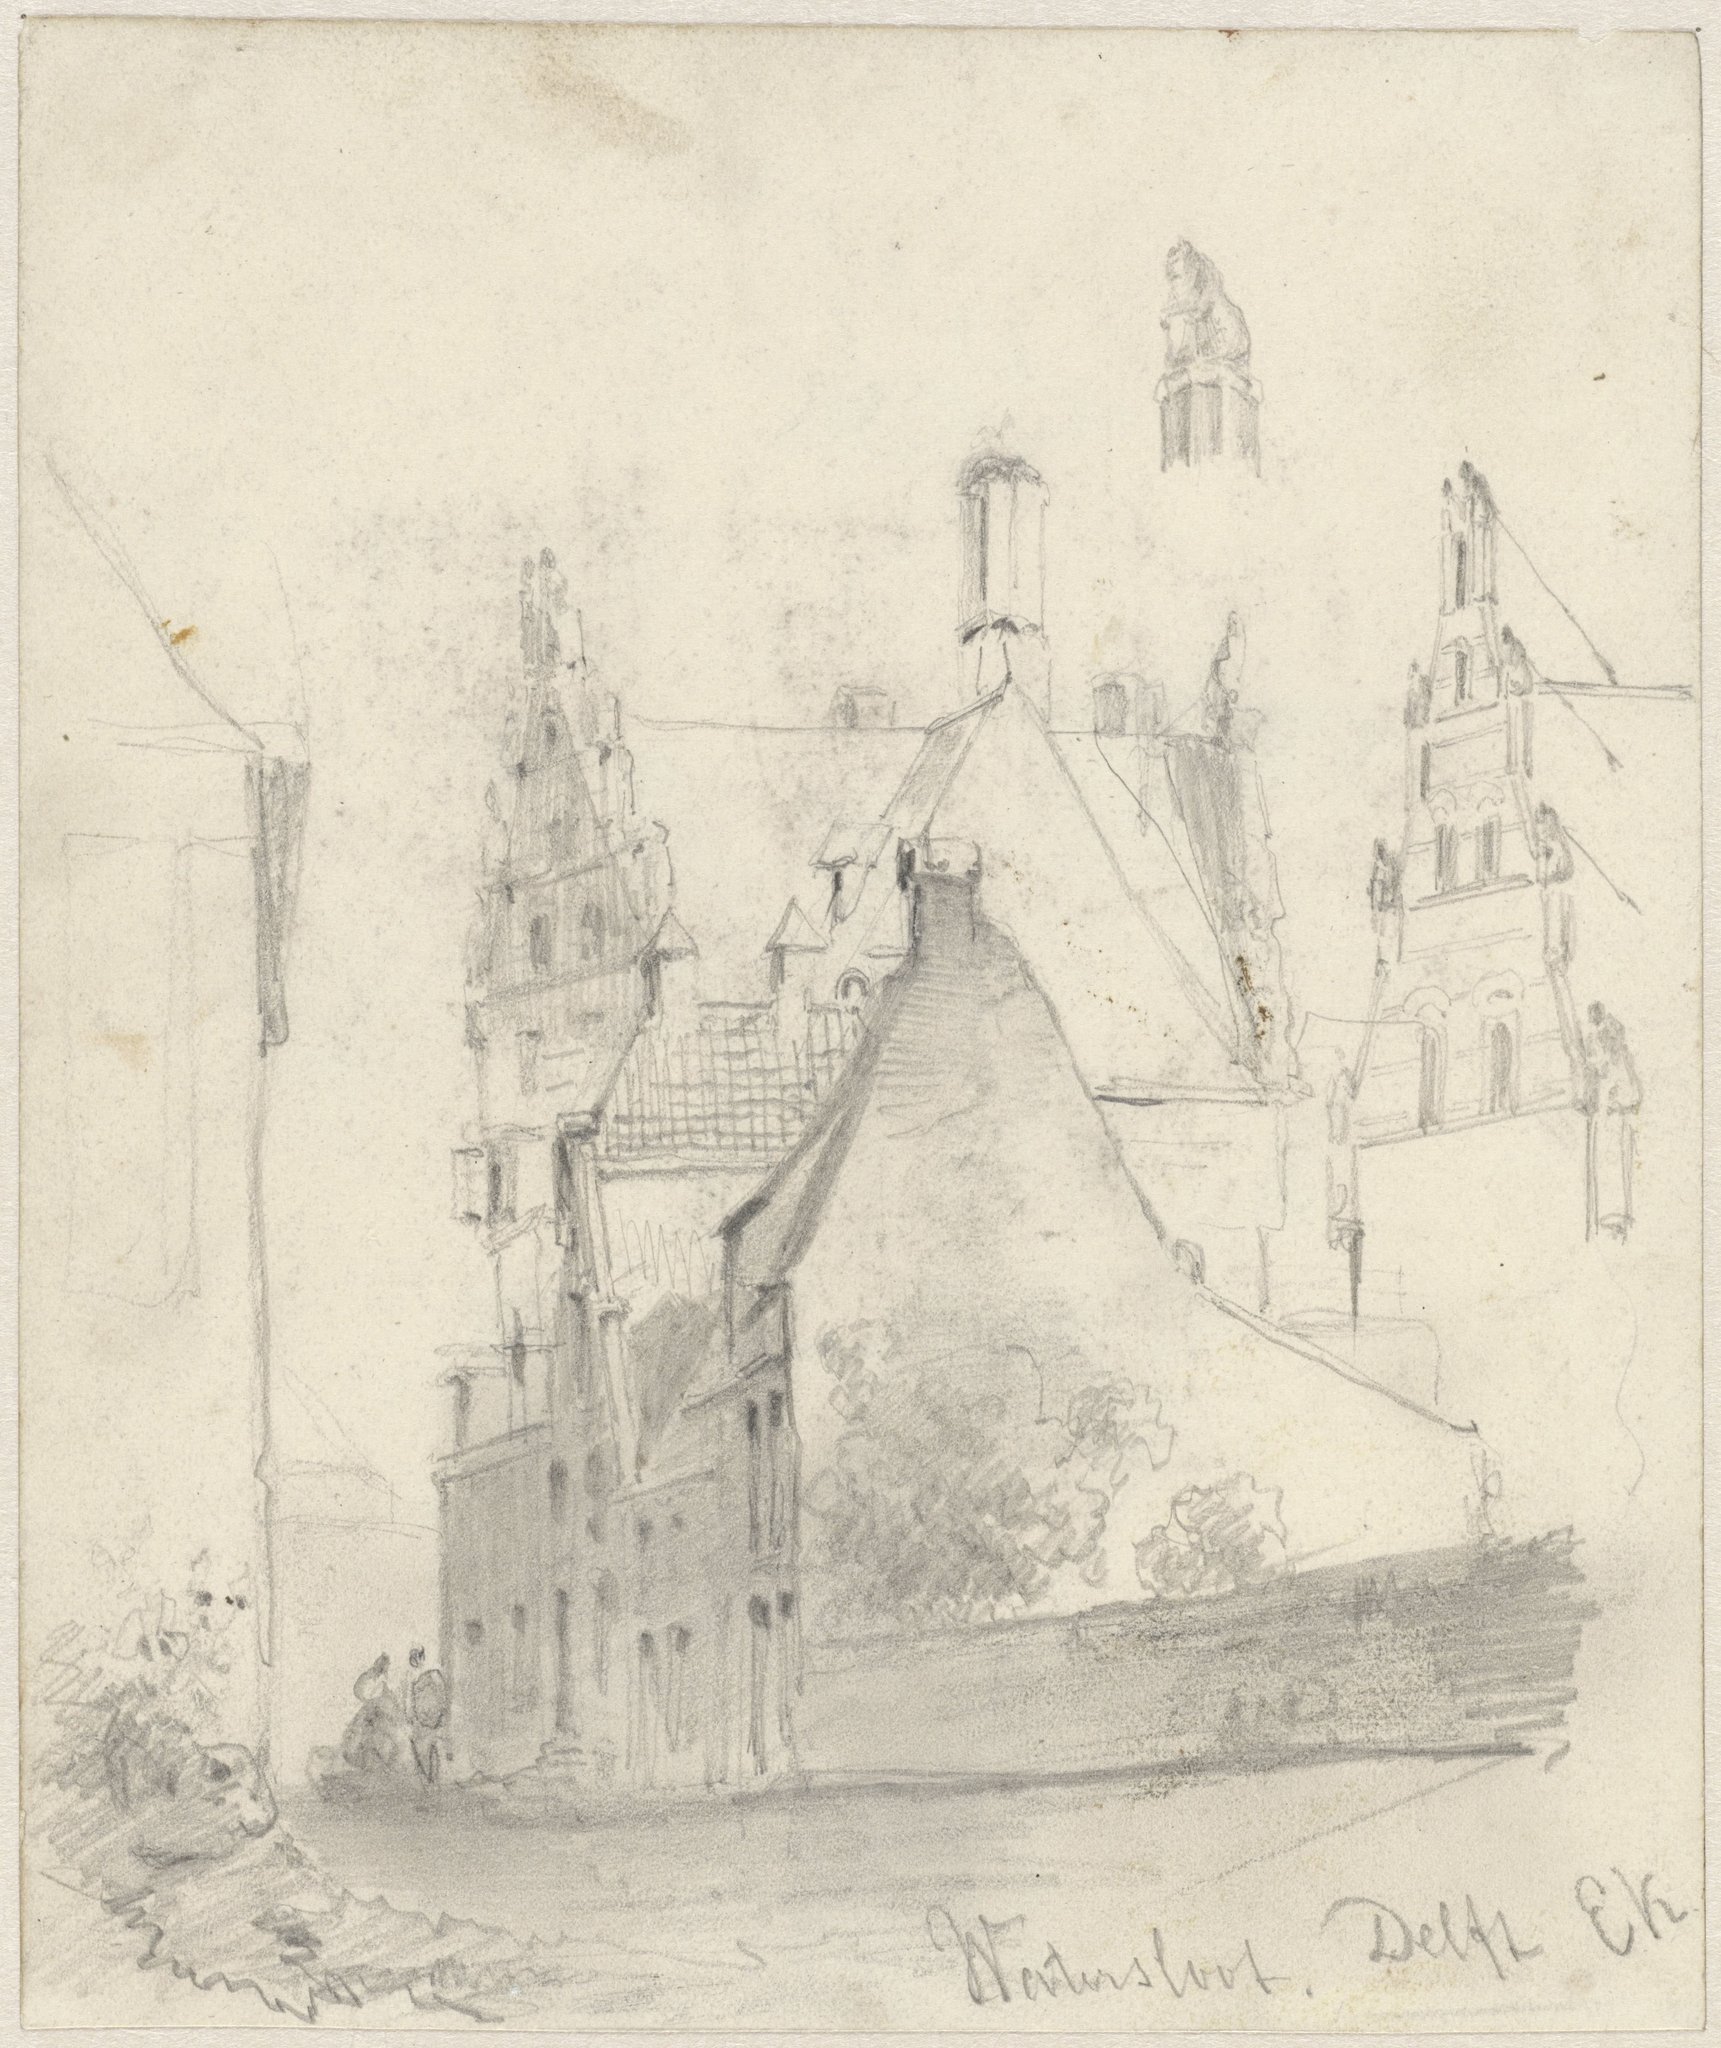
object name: drawing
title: Watersloot te Delft met enkele huizen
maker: everhardus koster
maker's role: draughtsman, painter, print maker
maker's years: 1817-1892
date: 1827-1892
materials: paper, pencil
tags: canals, waters (in city), delft